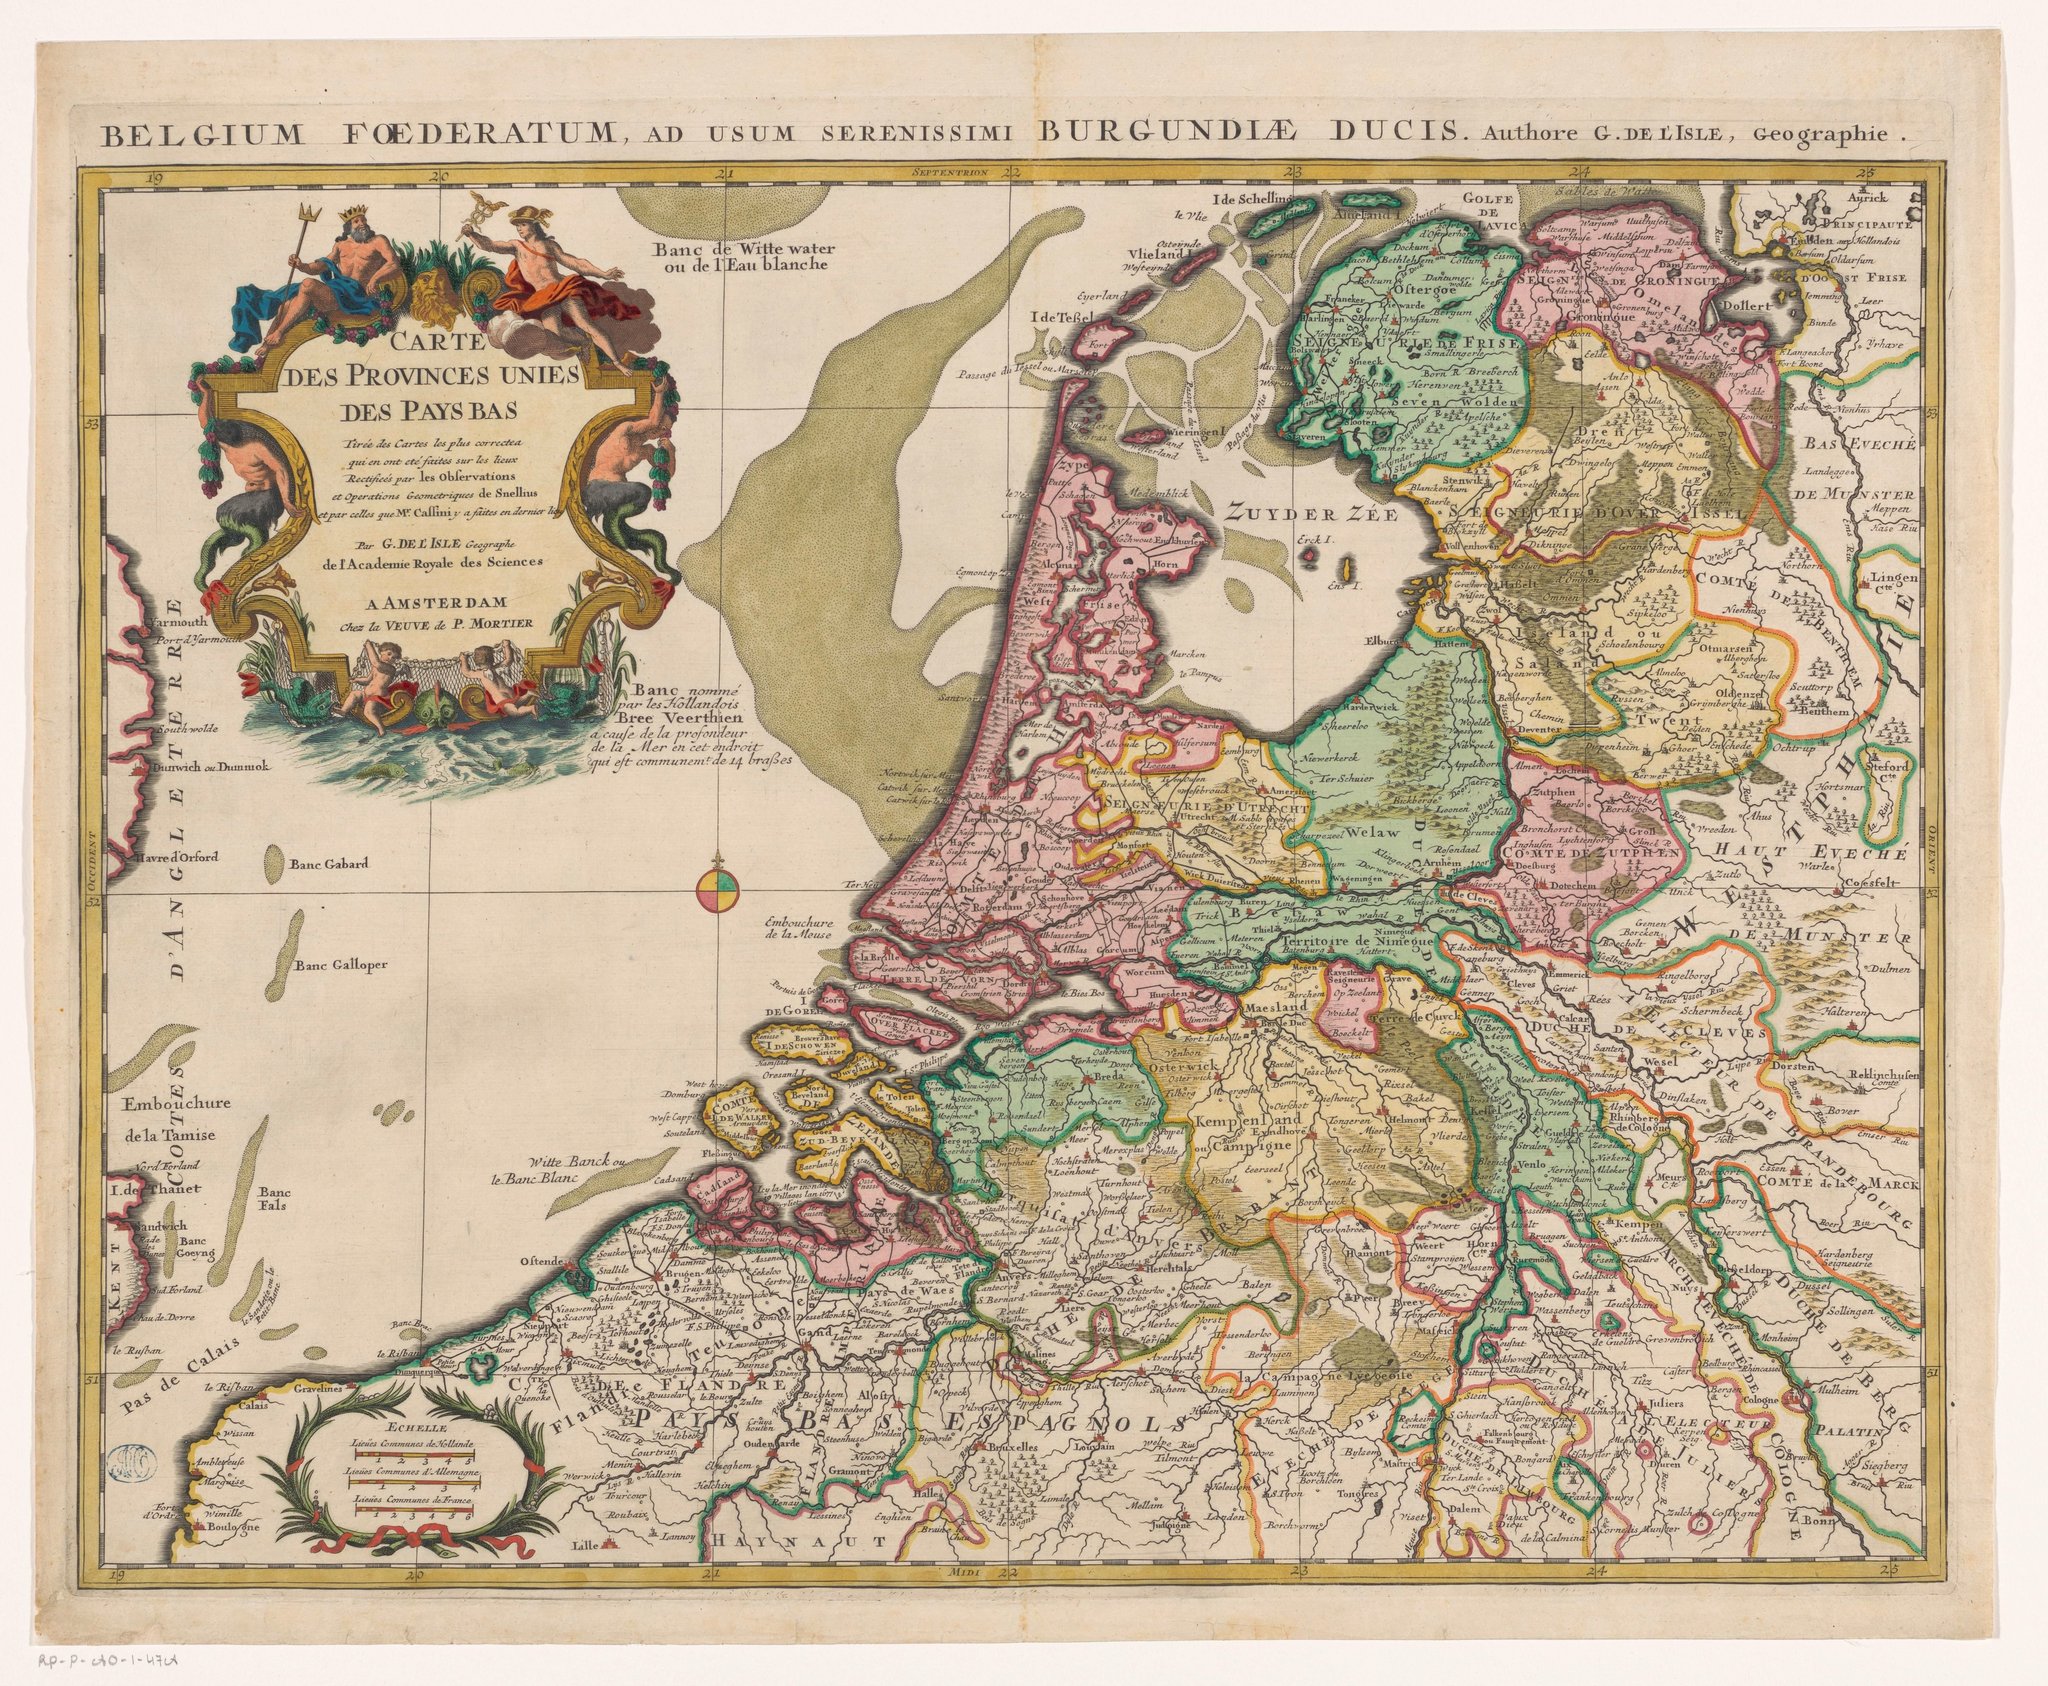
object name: map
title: Kaart van de Republiek der Zeven Verenigde Nederlanden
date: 1711-1719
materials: paper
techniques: engraving, etching, hand coloring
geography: amsterdam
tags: (story of) neptune (poseidon), triton(s), maps of separate countries or regions, (story of) mercury (hermes), netherlands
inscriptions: collector's mark: Lugt 195, collector's mark: Lugt 2228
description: Linksboven cartouche met titel, om cartouche zijn Neptunus, Mercurius, twee tritons en twee putti afgebeeld. Linksonder schaalstok: Lieües communes de Hollande, Lieües communes d'Allemagne, Lieües communes de France. De kaart is voorzien van een coördinaten-net en een gradenverdeling langs randen.